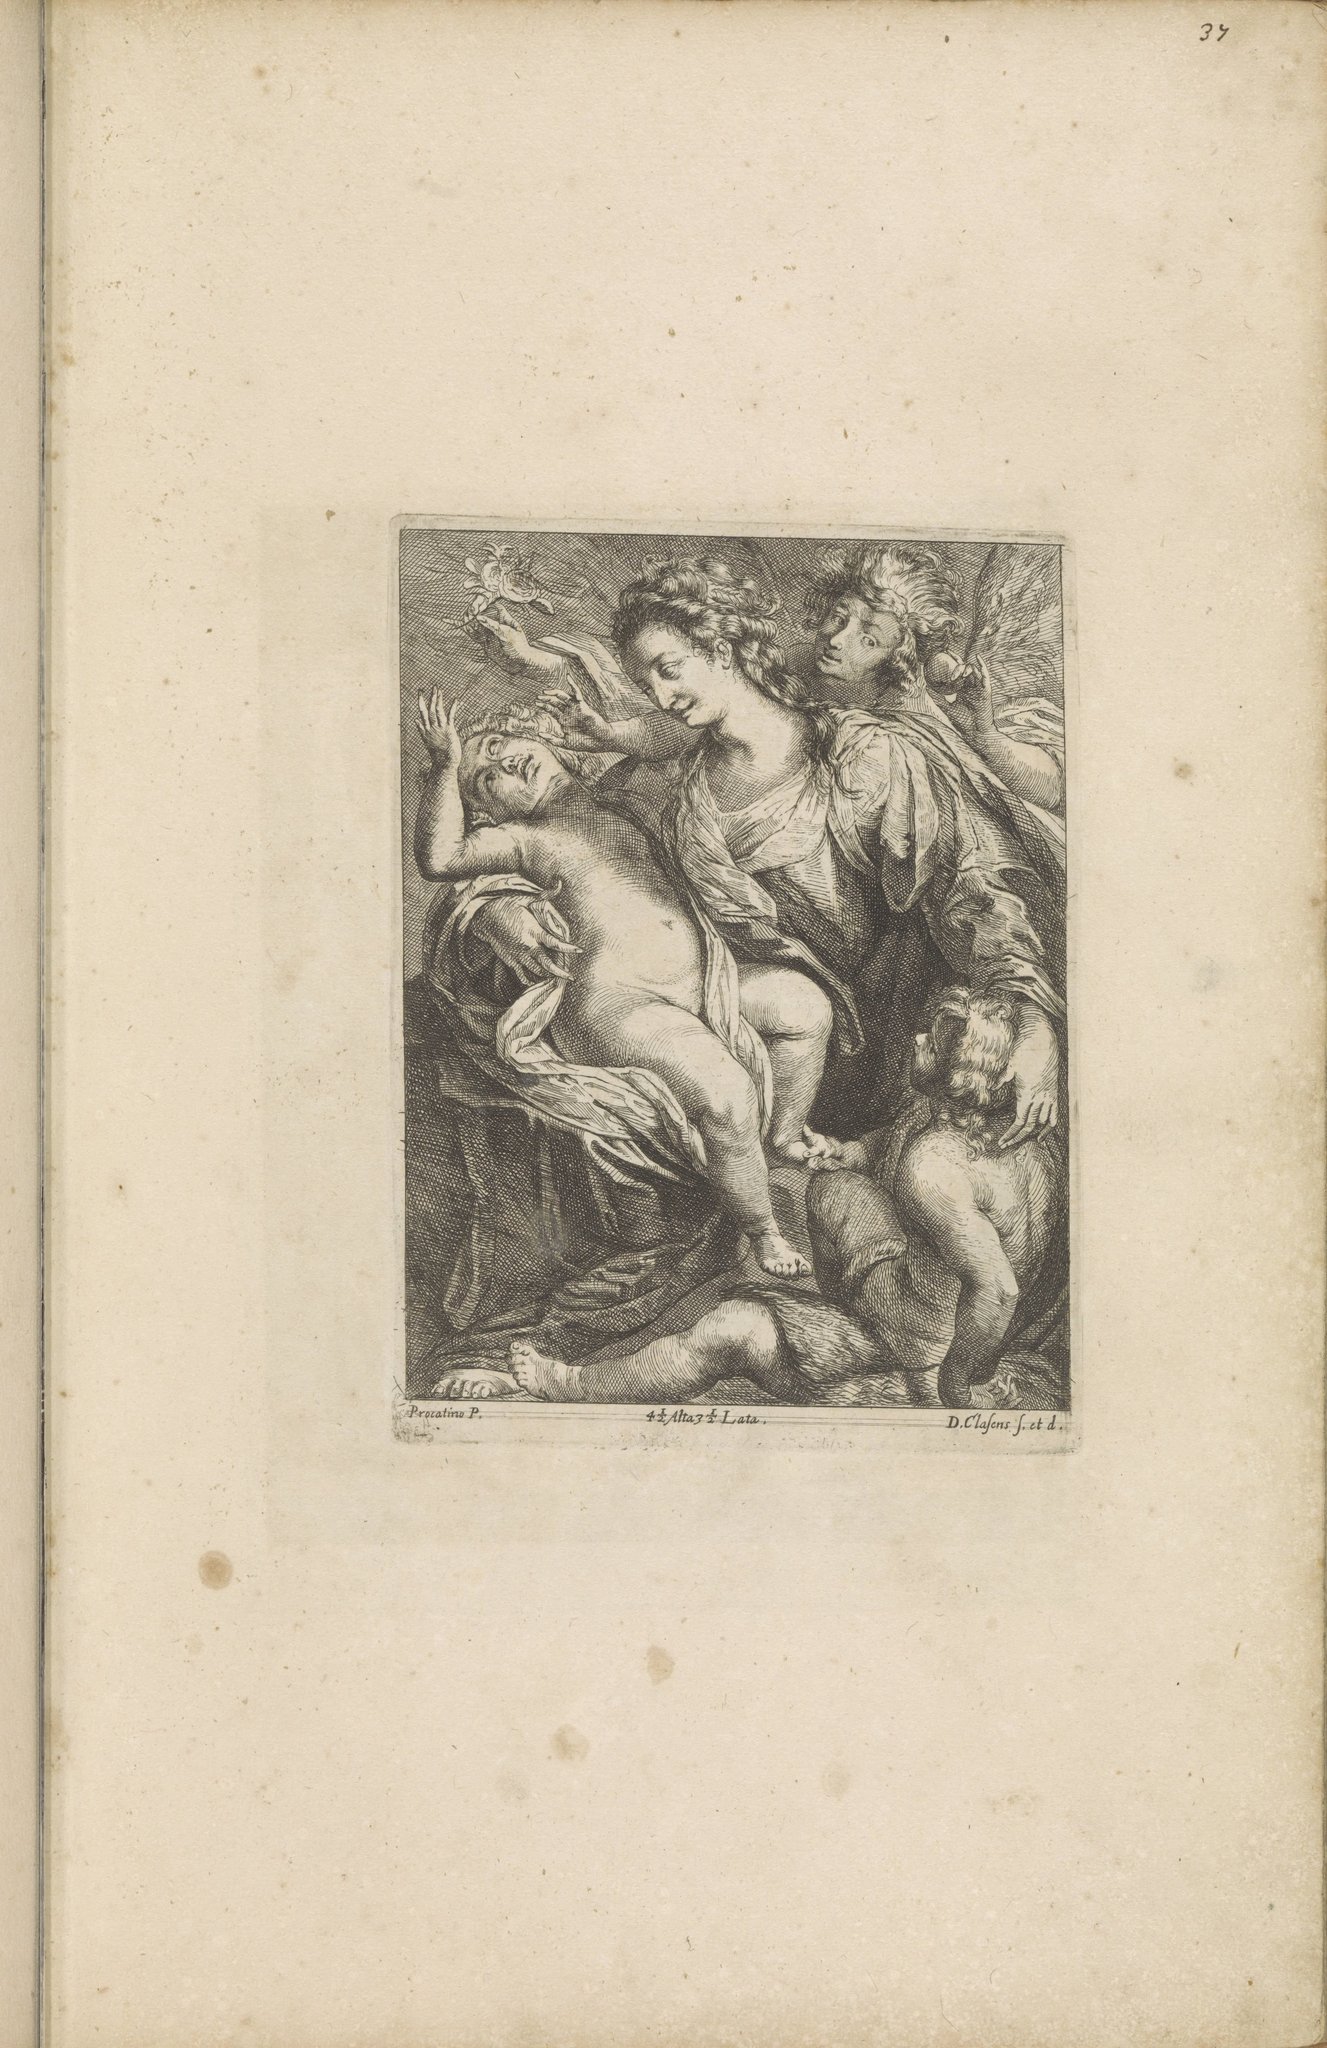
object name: print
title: Maria met het Christuskind en de H. Johannes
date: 1660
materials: paper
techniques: engraving, etching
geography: italy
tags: mary and the christ-child with john the baptist (as child) (+ angel(s))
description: De prent is vervaardigd naar het schilderij van Procaccini dat zich in de collectie van het Kunsthistorisches Museum te Wenen bevindt (inventarisnummer GG_1617). David Teniers heeft waarschijnlijk van alle schilderijen uit de collectie van Leopold Willem van Oostenrijk een olieverfstudie op doek of paneel vervaardigd (zgn. pasticcio), die als voorbeeld voor de prentmakers diende. Het is niet altijd duidelijk of de pasticci door hem zijn gemaakt of door zijn atelier. Niet alle pasticci zijn overgeleverd.